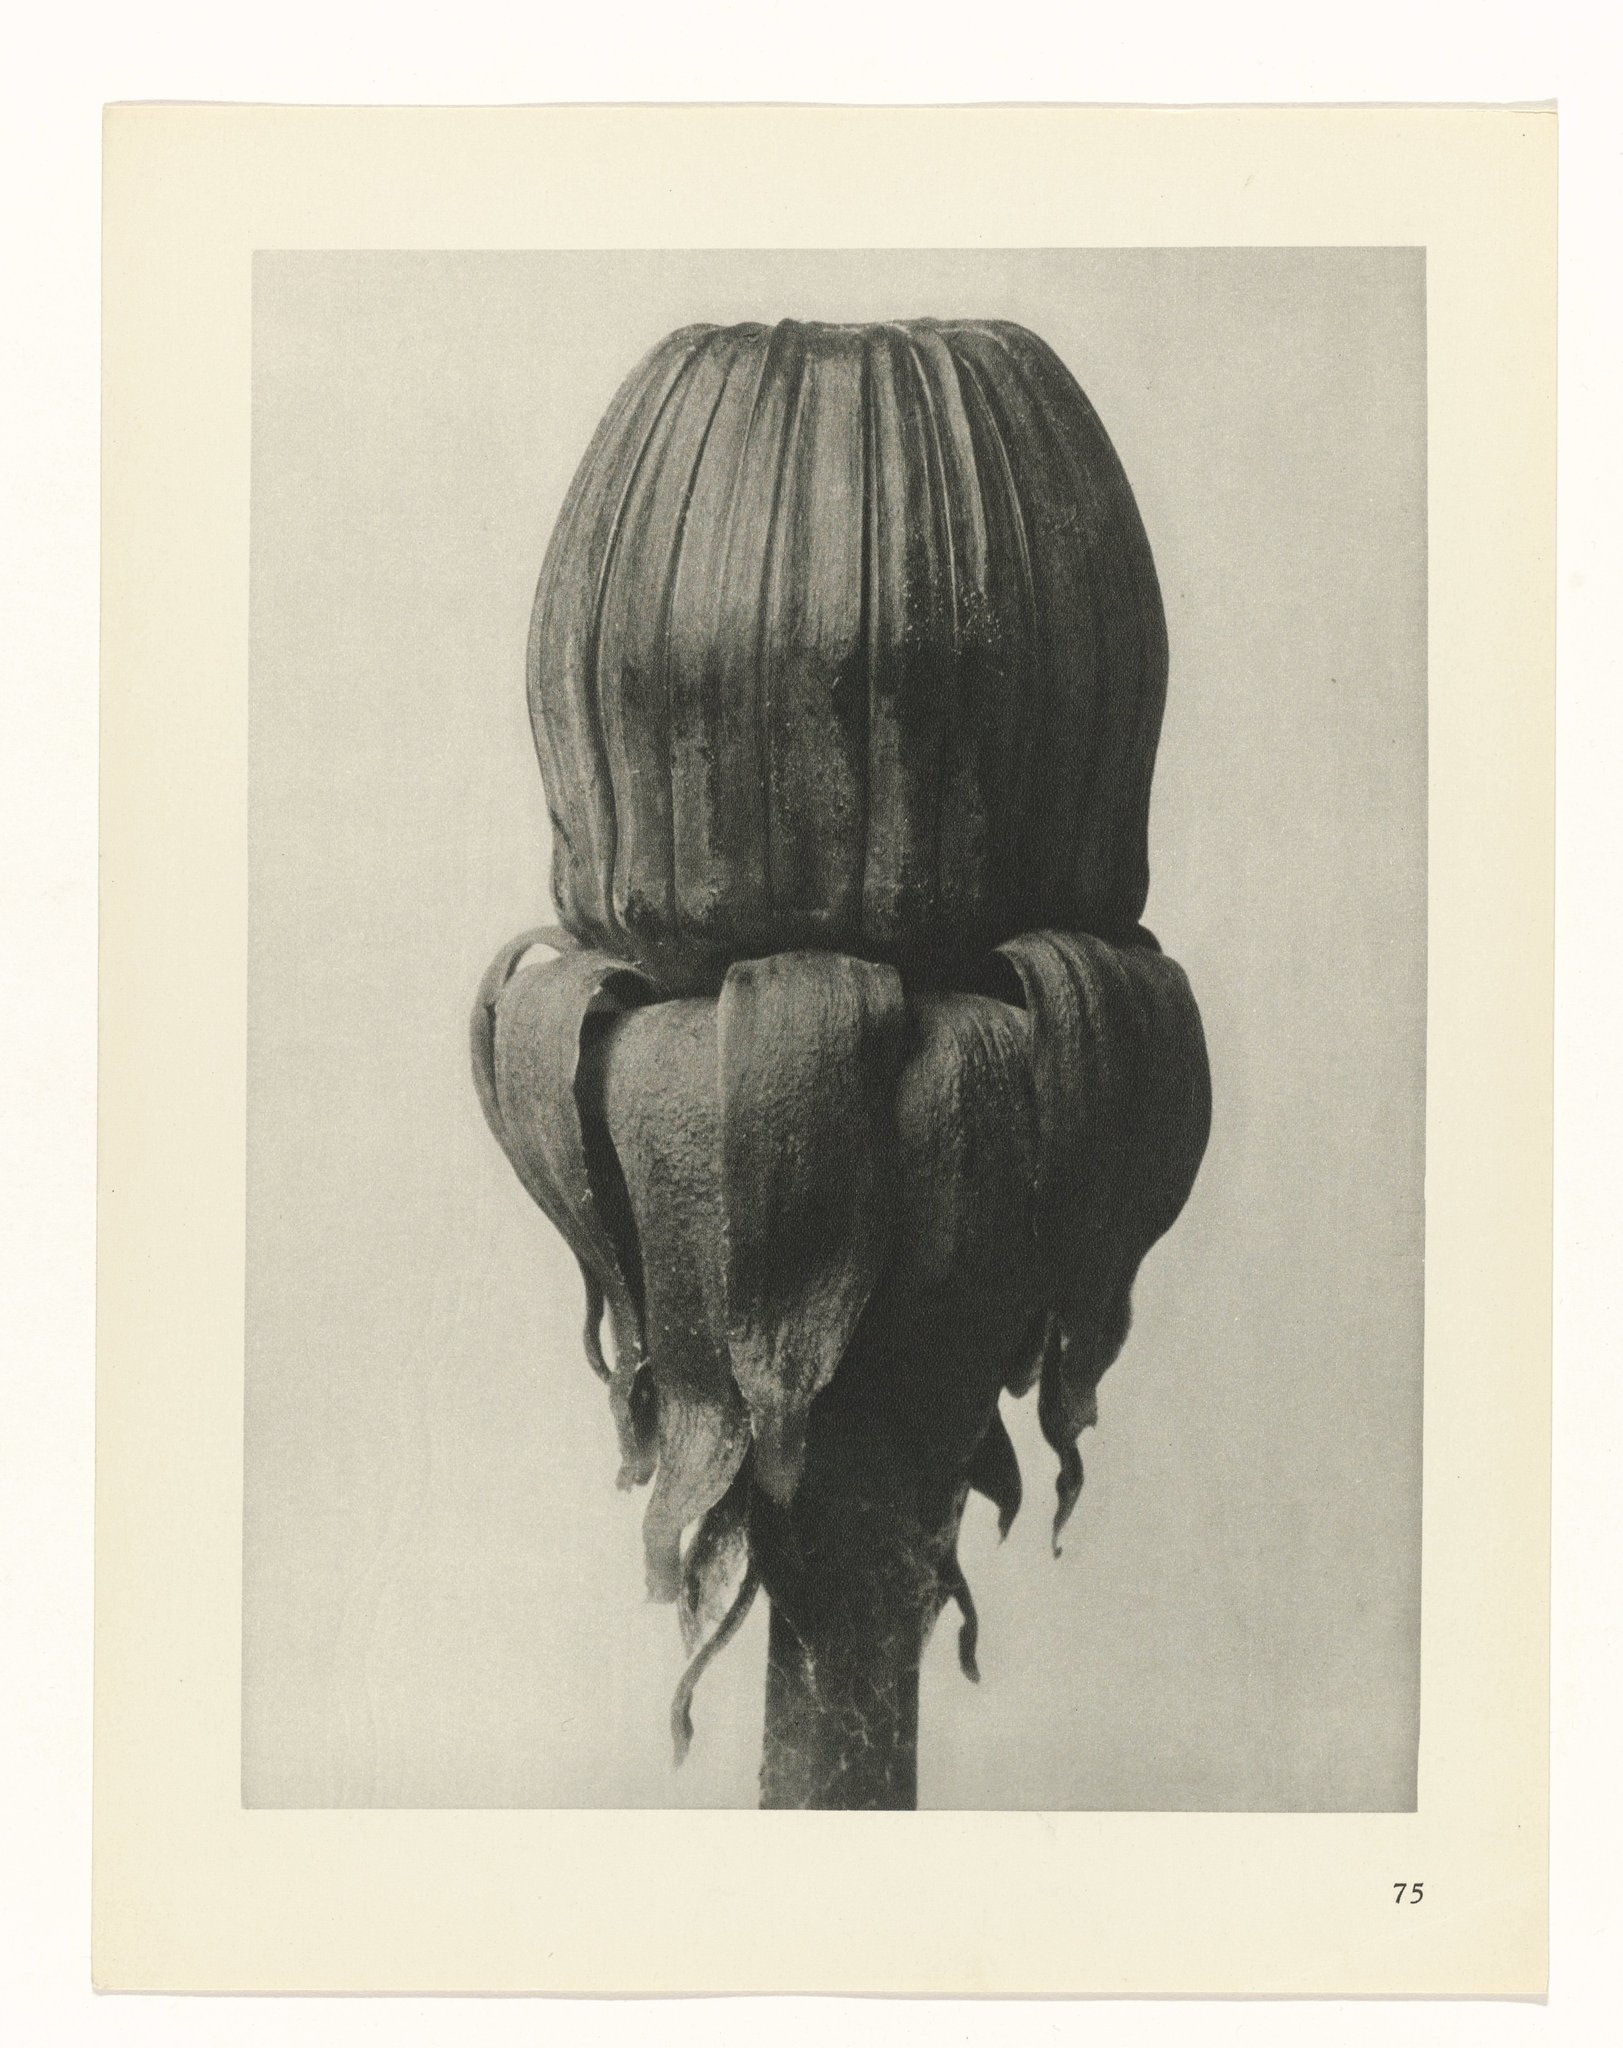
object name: photograph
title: Urformen der Kunst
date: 1928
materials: ink, paper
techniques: rotogravure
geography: berlin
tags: plants (in general)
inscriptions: number: ‘75’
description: facher Vergrößerung. Afkomstig uit losbladige uitgave.